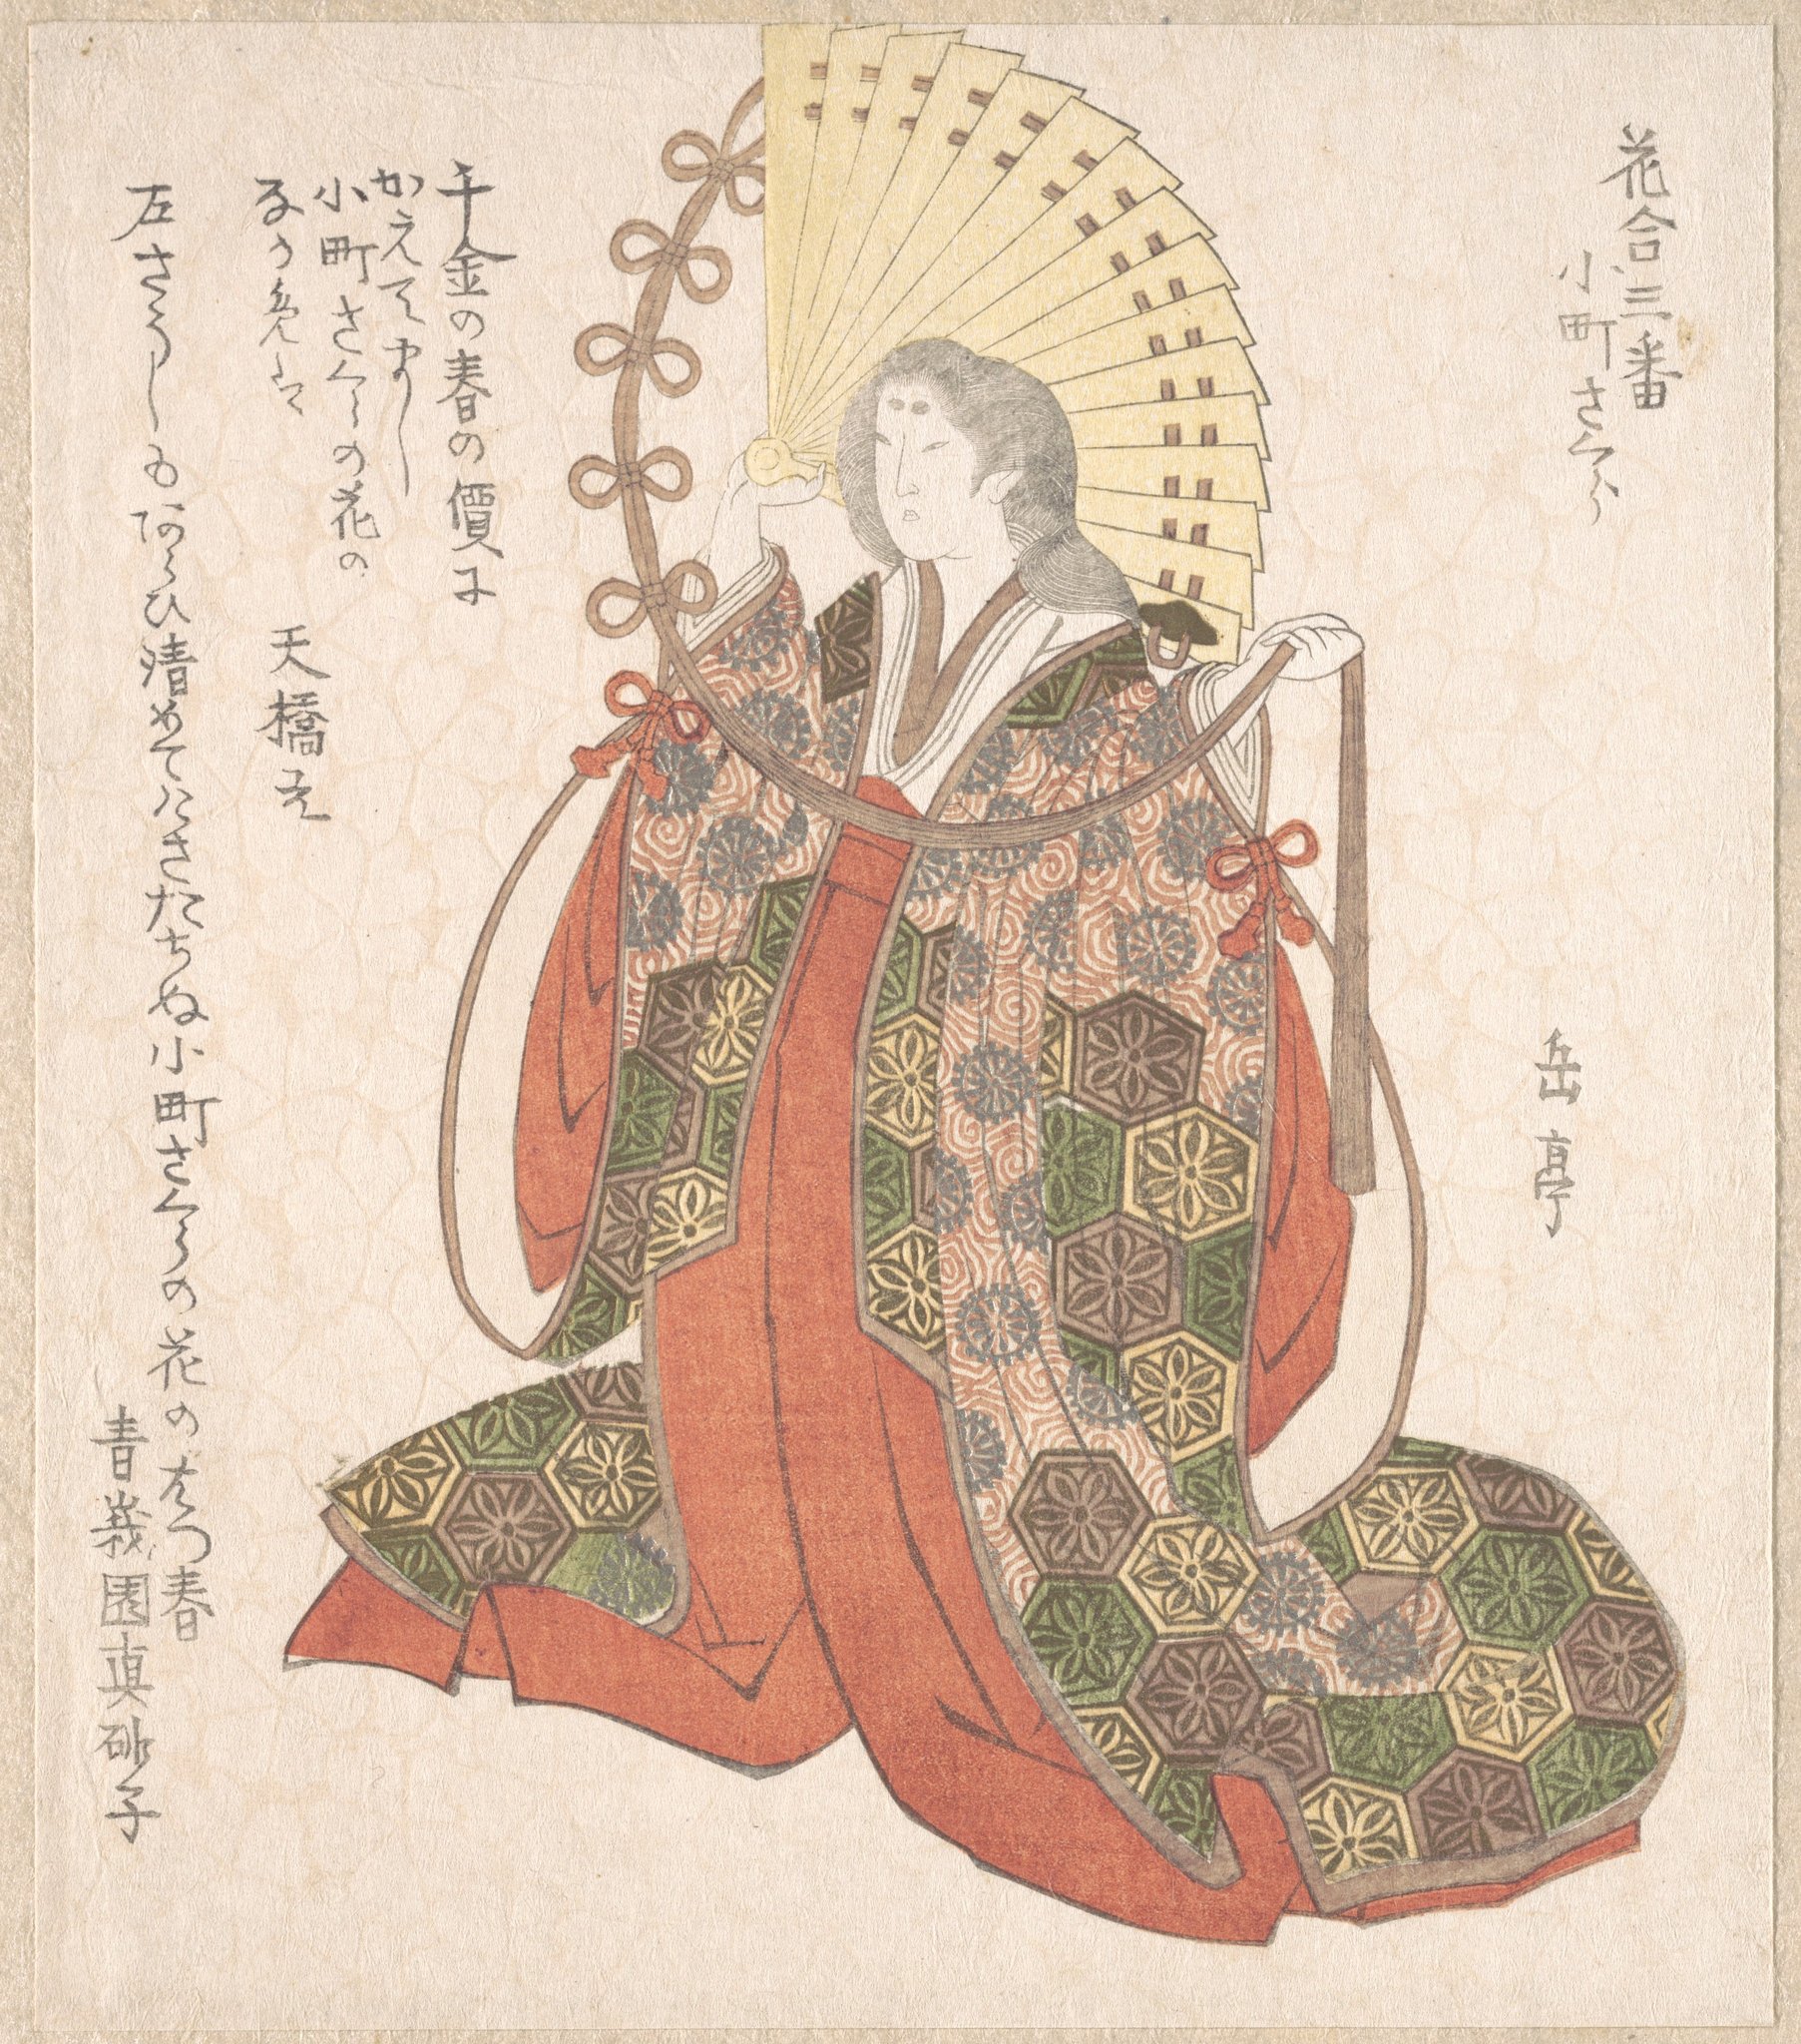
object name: print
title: Lady Komachi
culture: japanese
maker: yashima gakutei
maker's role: artist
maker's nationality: japanese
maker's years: 1786-1868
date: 1801-1900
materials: ink, paper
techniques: surimono, woodblock print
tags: fans,women